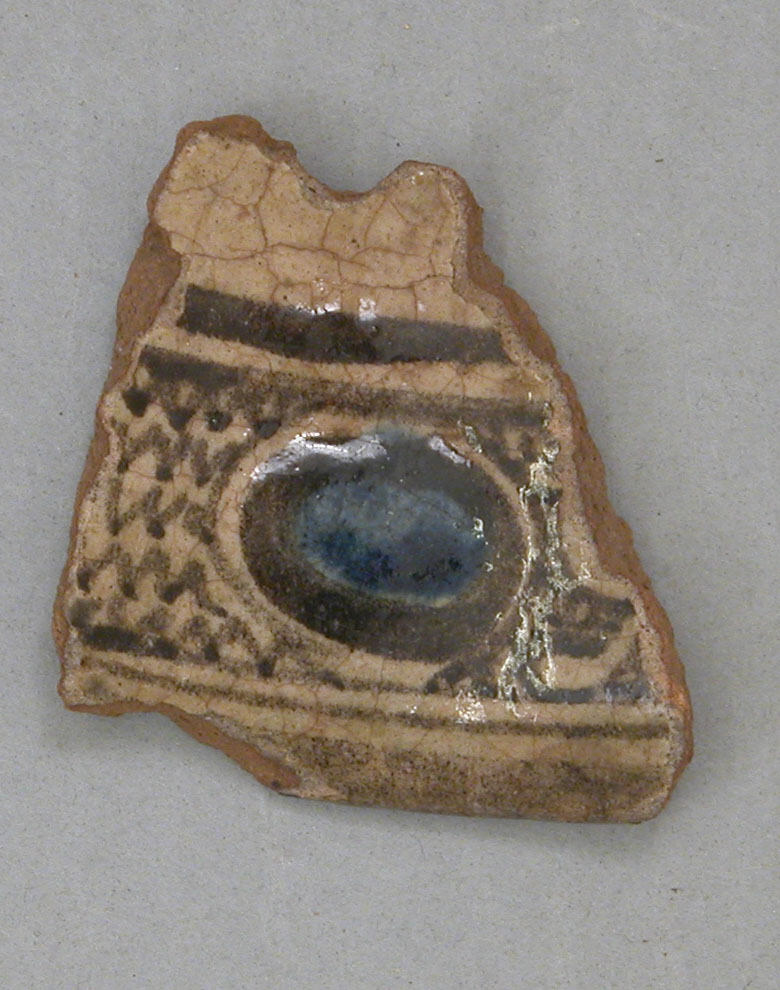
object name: fragment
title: Ceramic Fragment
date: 1301-1500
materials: earthenware, glaze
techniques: painting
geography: egypt